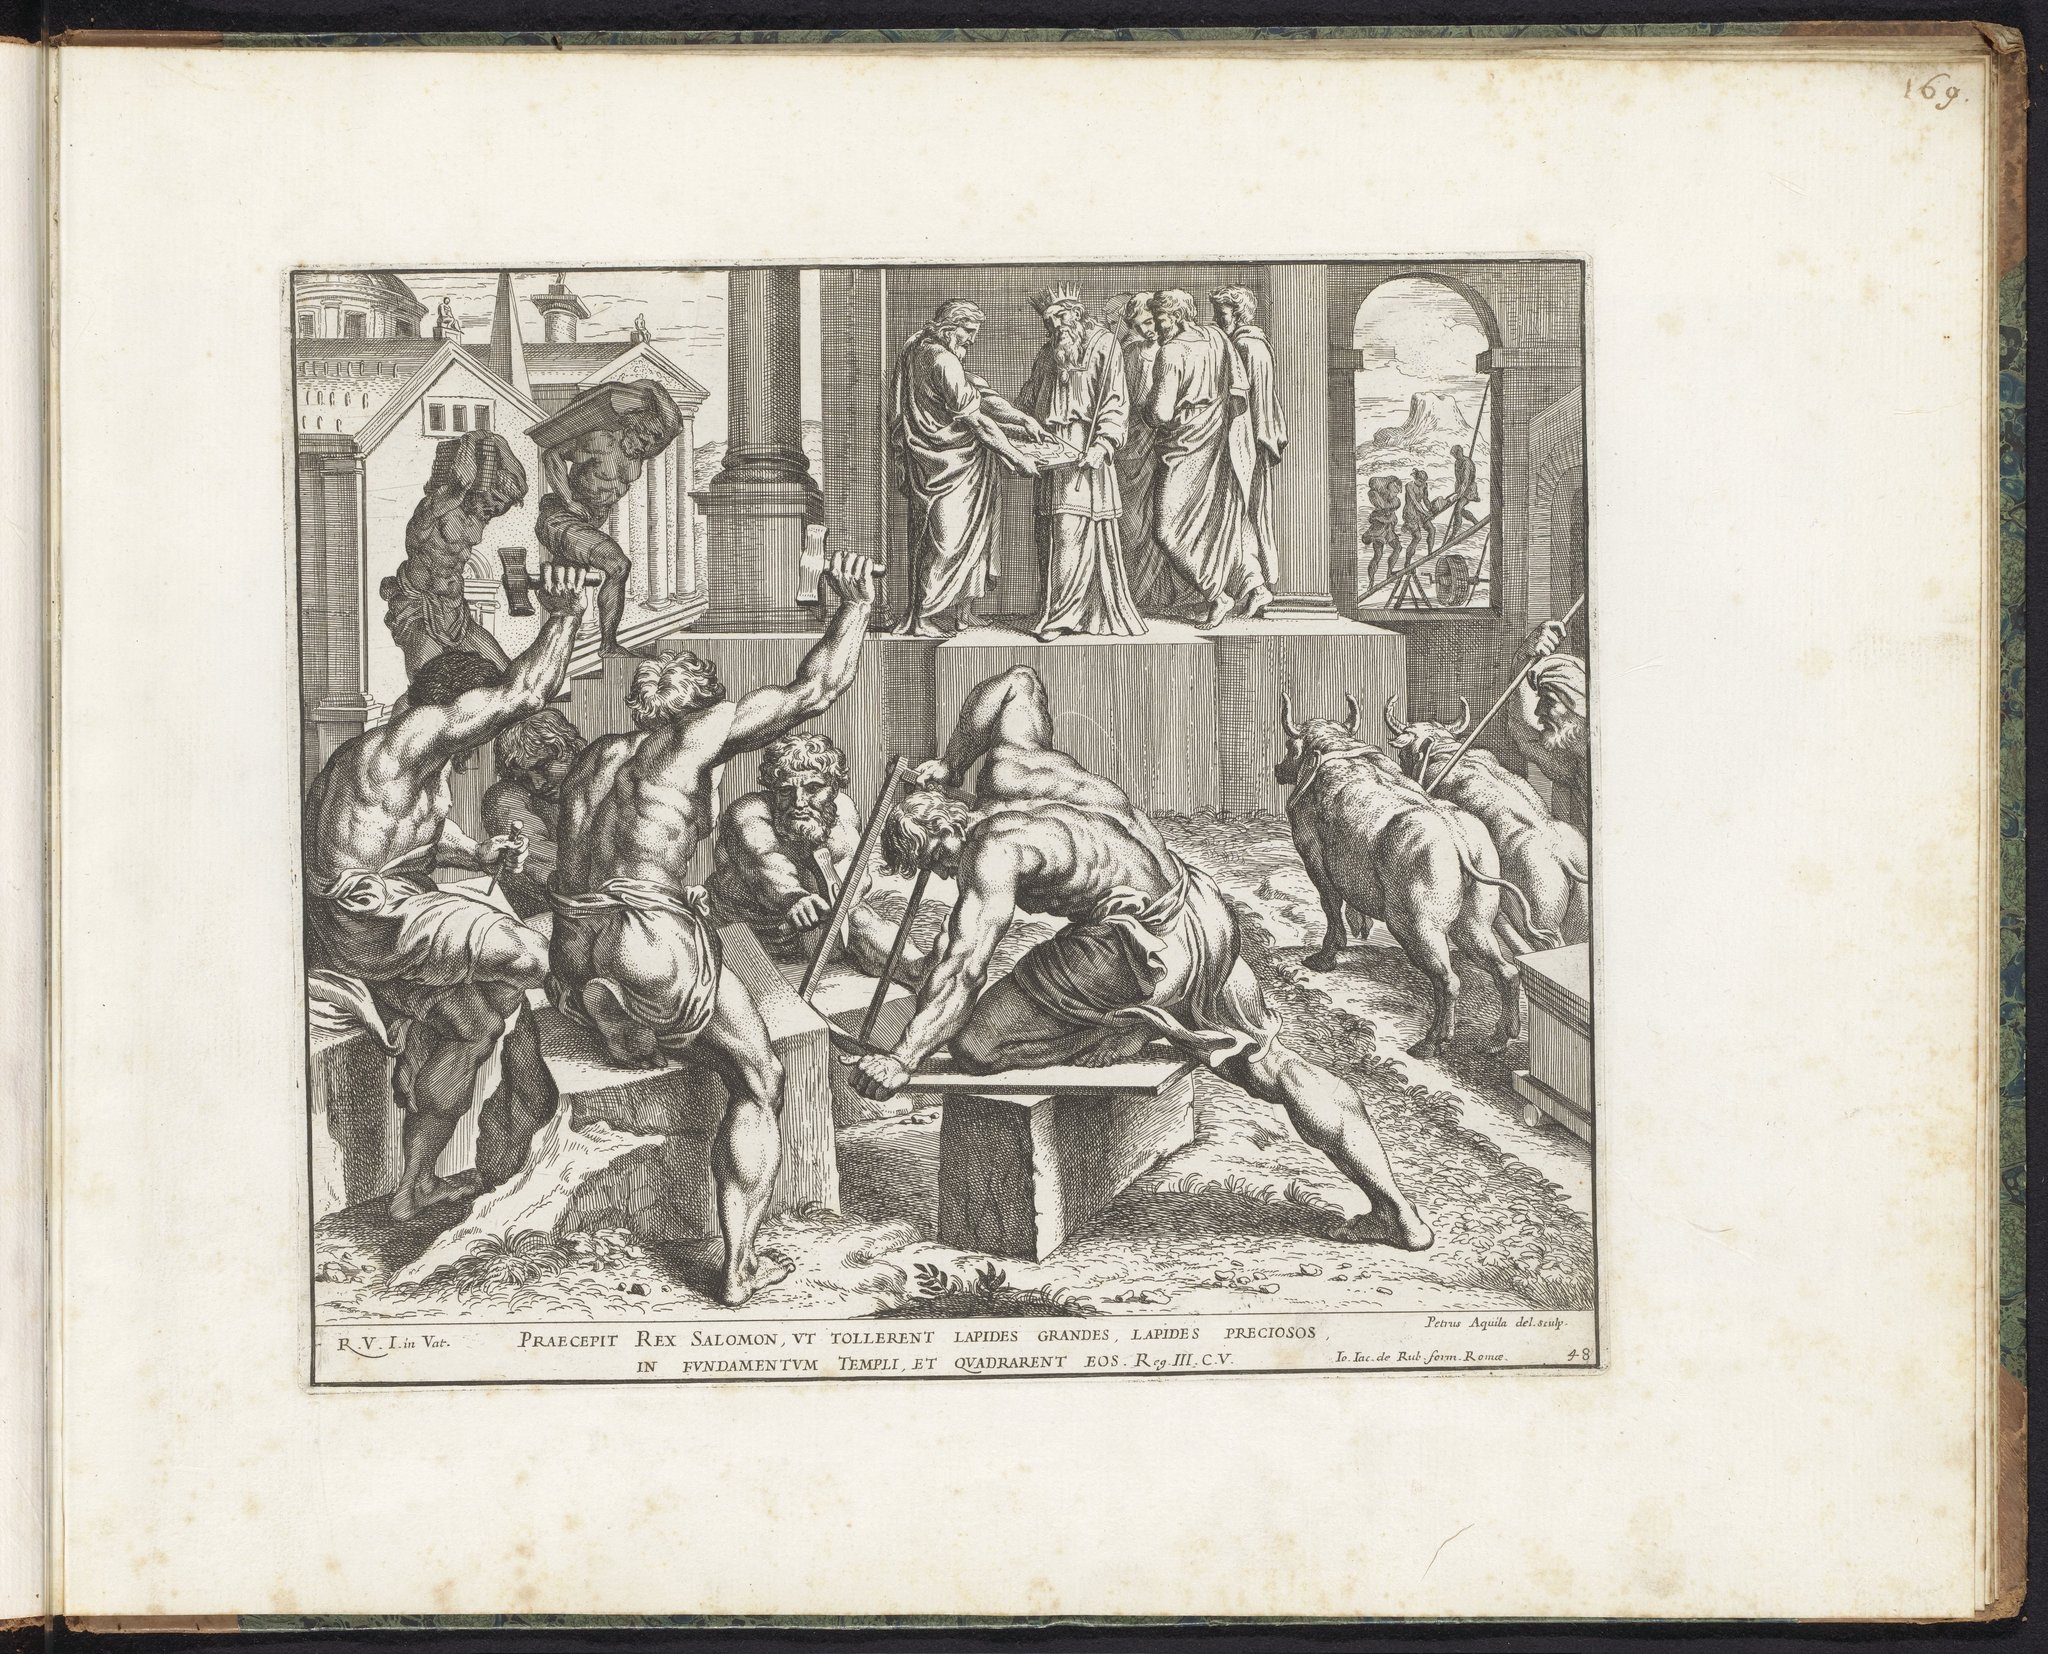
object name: album leaf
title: Salomo bouwt de tempel in Jerusalem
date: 1675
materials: paper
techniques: etching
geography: italy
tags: the building of the temple of solomon, solomon supervising the work ~ temple of solomon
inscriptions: number: ‘169’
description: Een groep mannen is in de weer met gereedschappen en bouwmaterialen. Ze bouwen aan de Tempel van Salomo. Op de achtergrond staat Koning Salomo die toeziet op de werkzaamheden. Bijbelvers onder de voorstelling. Prent maakt deel uit van een album.